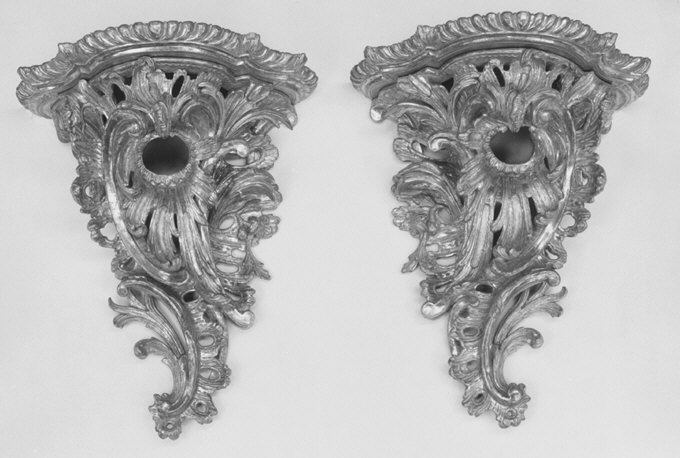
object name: wall bracket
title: Pair of wall brackets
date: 1735-1740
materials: wood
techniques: carving, gilding